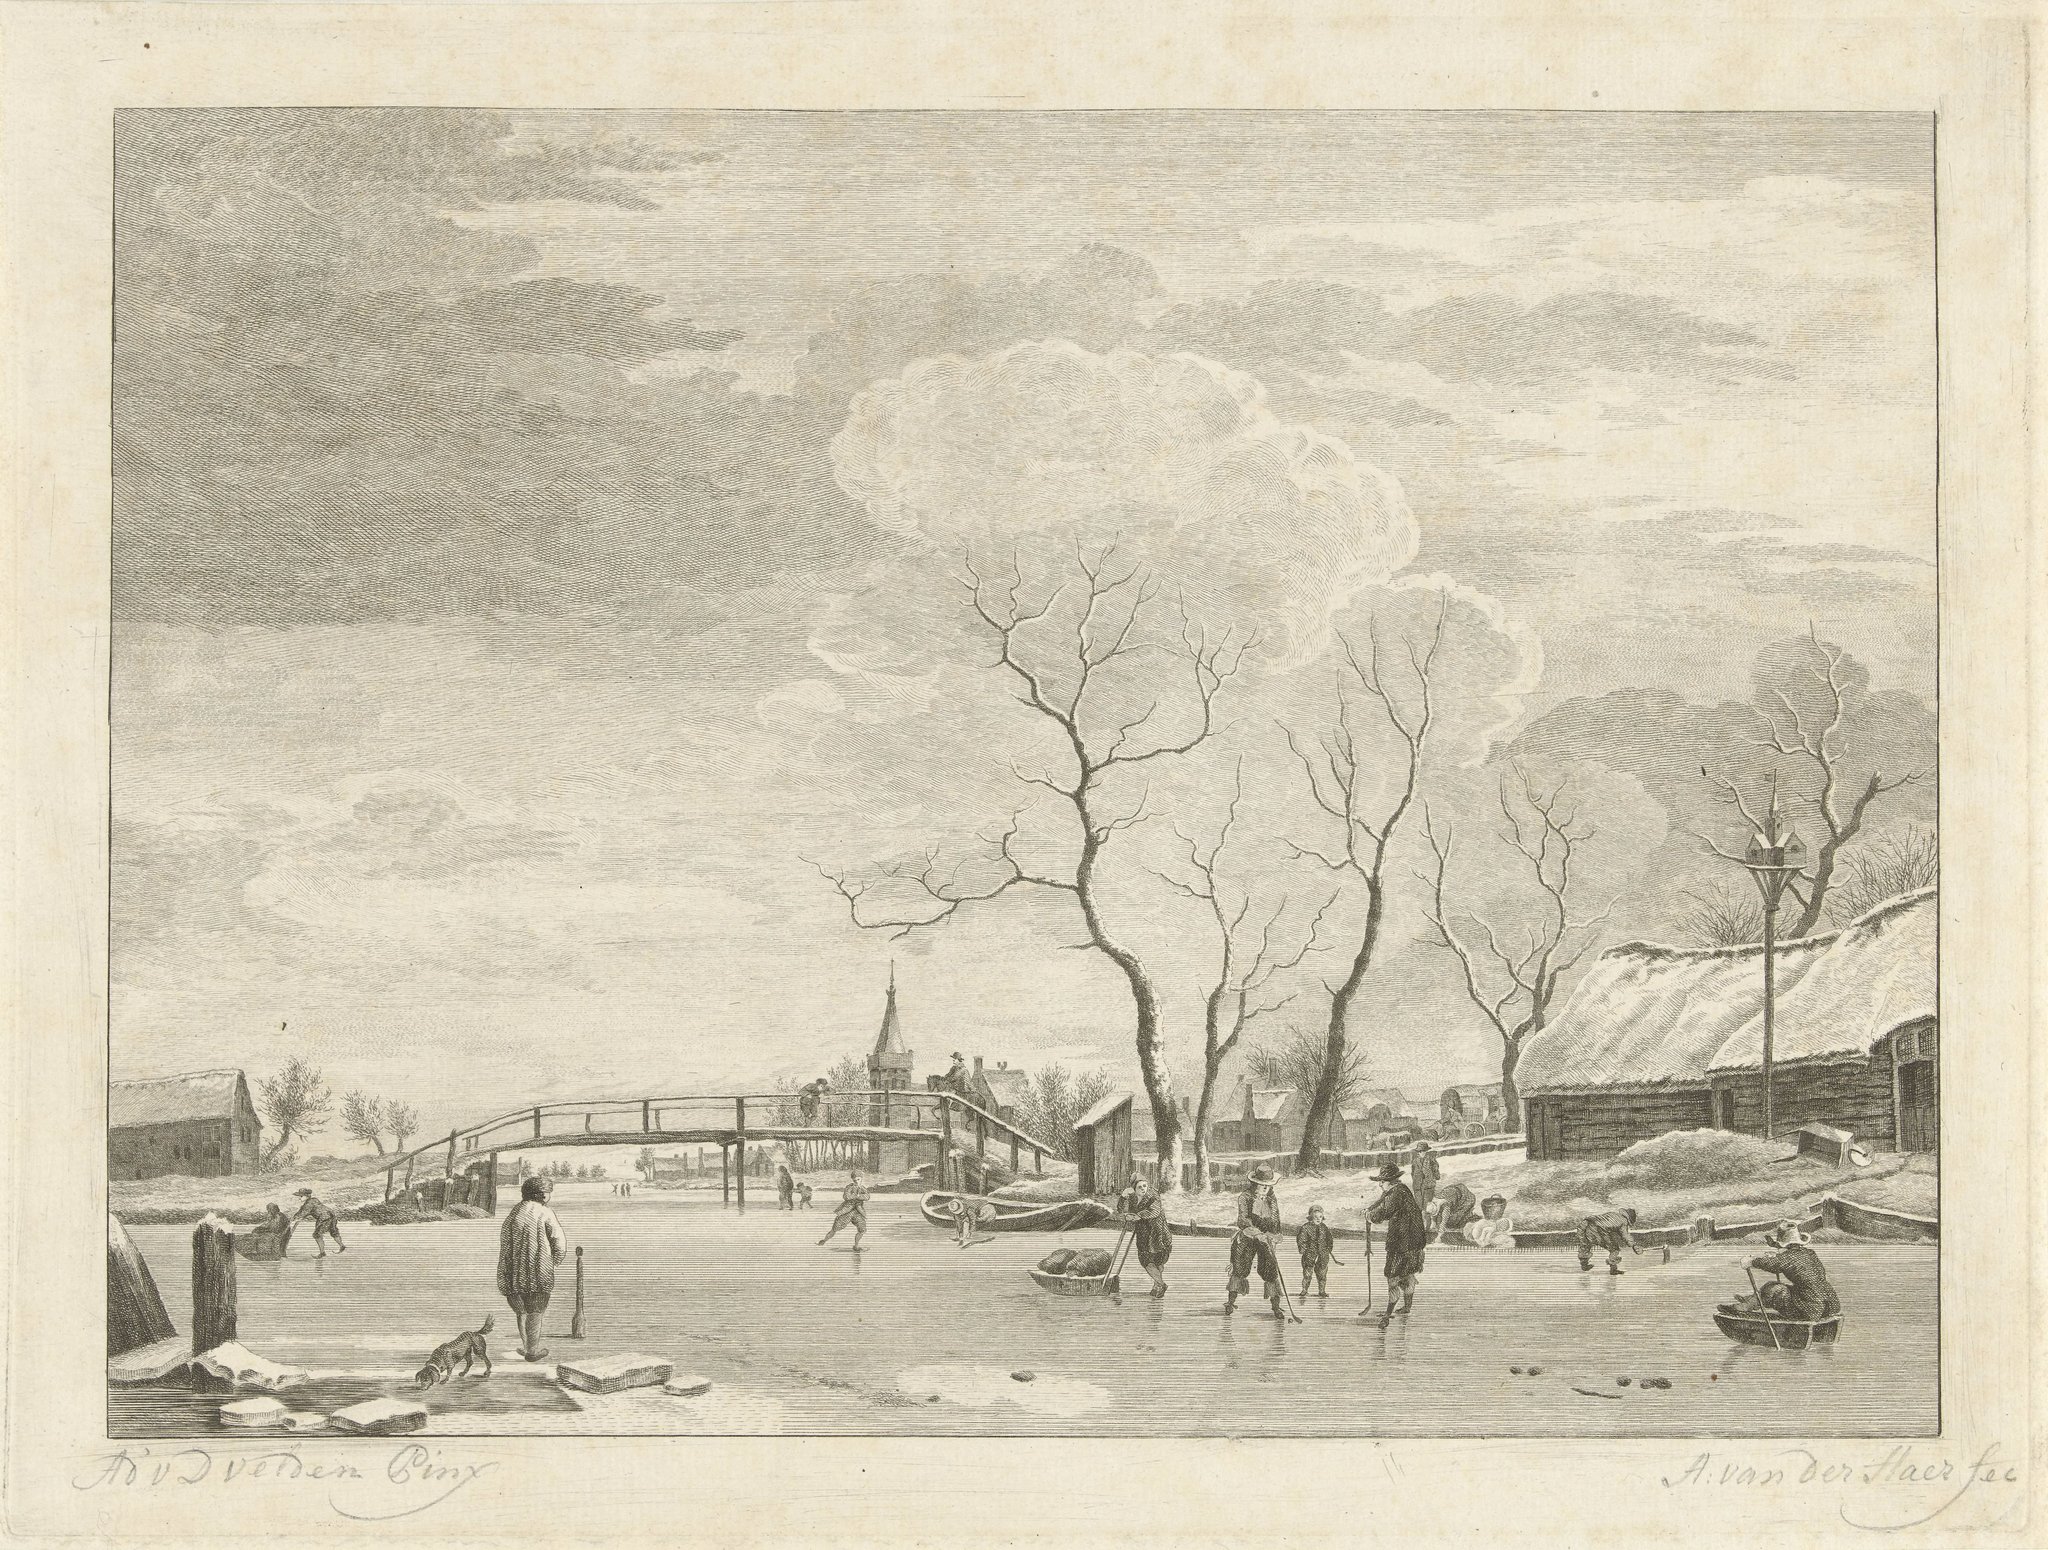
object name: print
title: Schaaters bij een dorp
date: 1745-1785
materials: paper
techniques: etching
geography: northern netherlands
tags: landscape with bridge, viaduct or aqueduct, skates (winter sports), village (+ city(-scape) with figures, staffage), small sleigh (winter sports)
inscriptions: collector's mark: Lugt 2228, name: ‘A. van der Haer fec’, name: ‘A vd Velden Pinx’